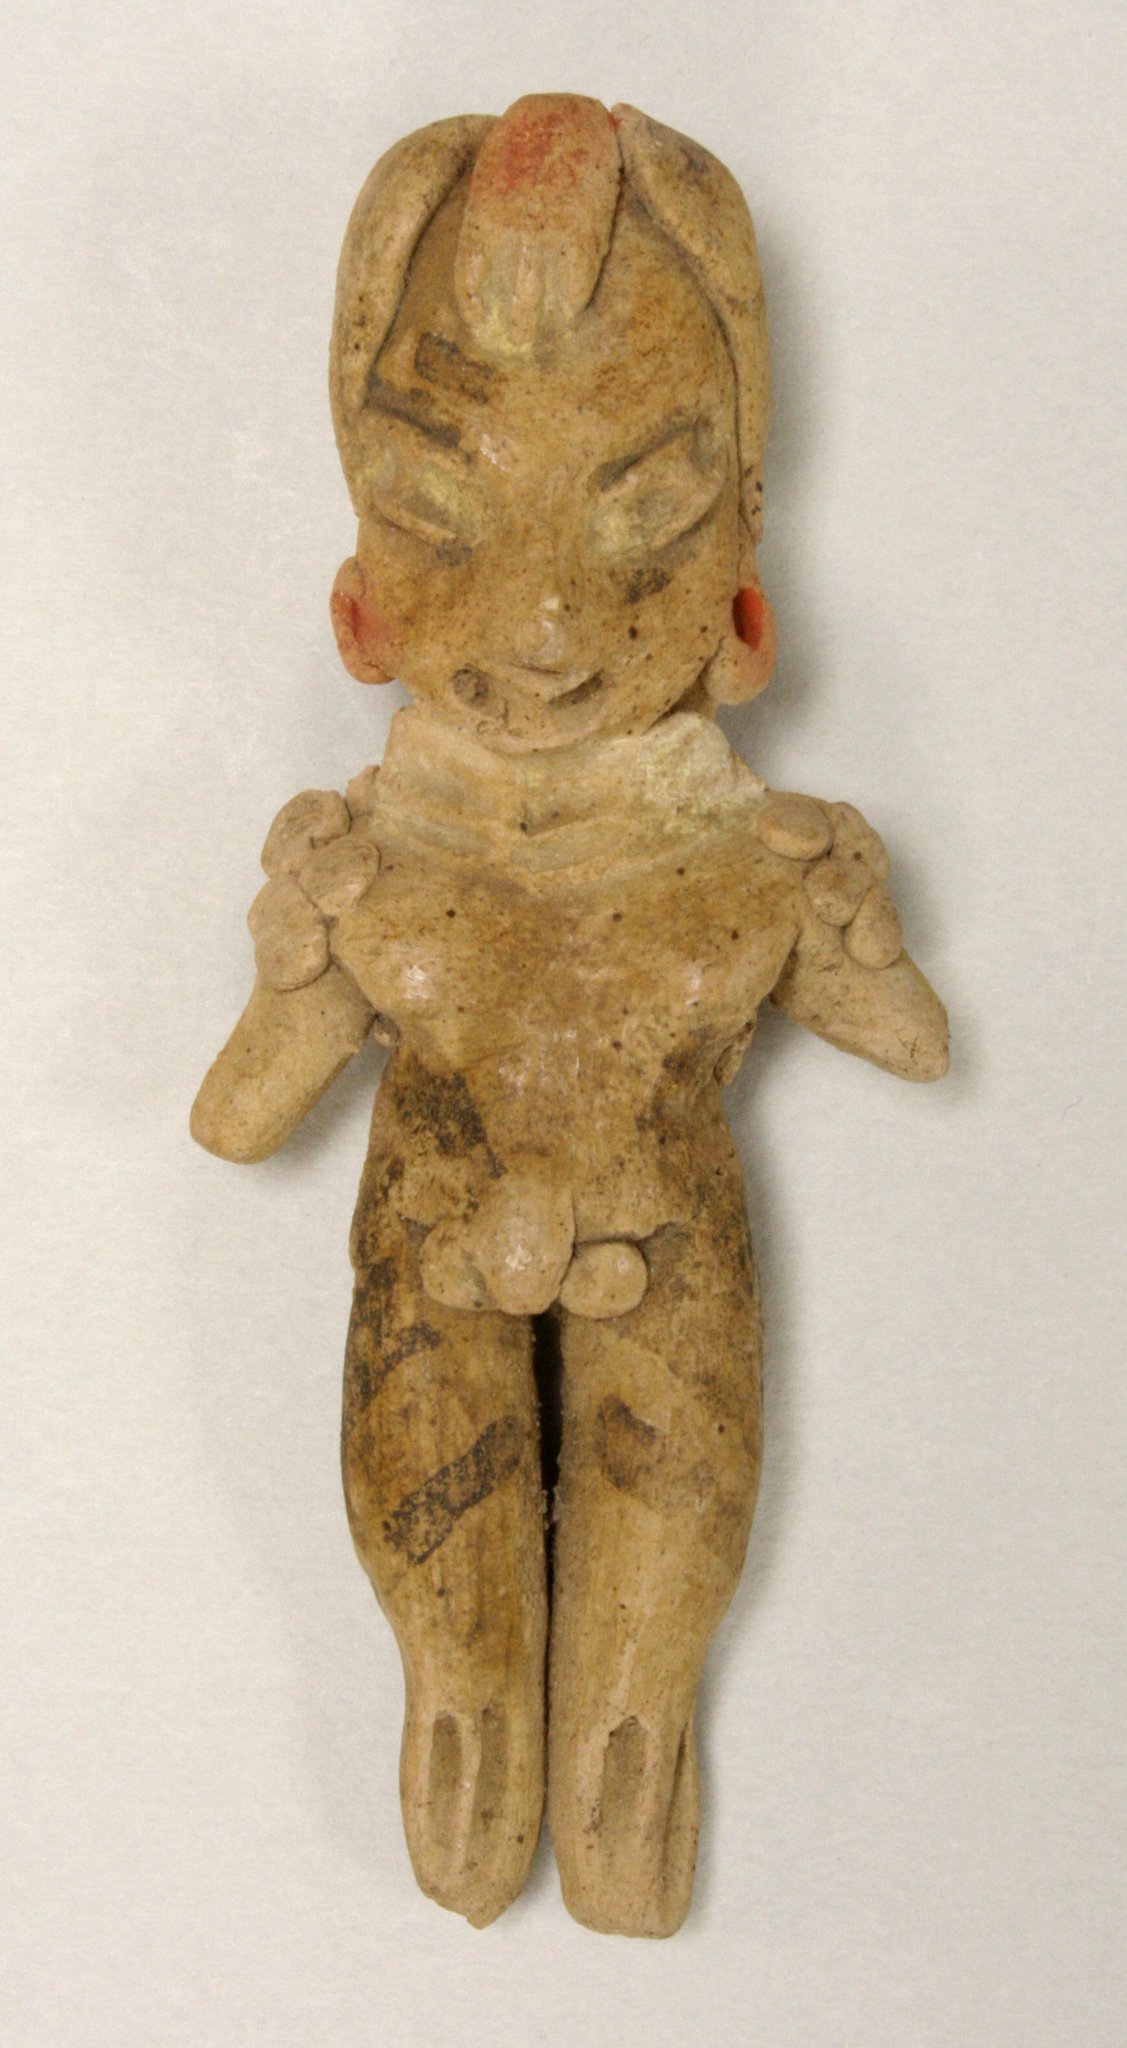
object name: male figure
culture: chupicuaro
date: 300 BCE-400 CE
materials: ceramic, pigment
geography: mexico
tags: men